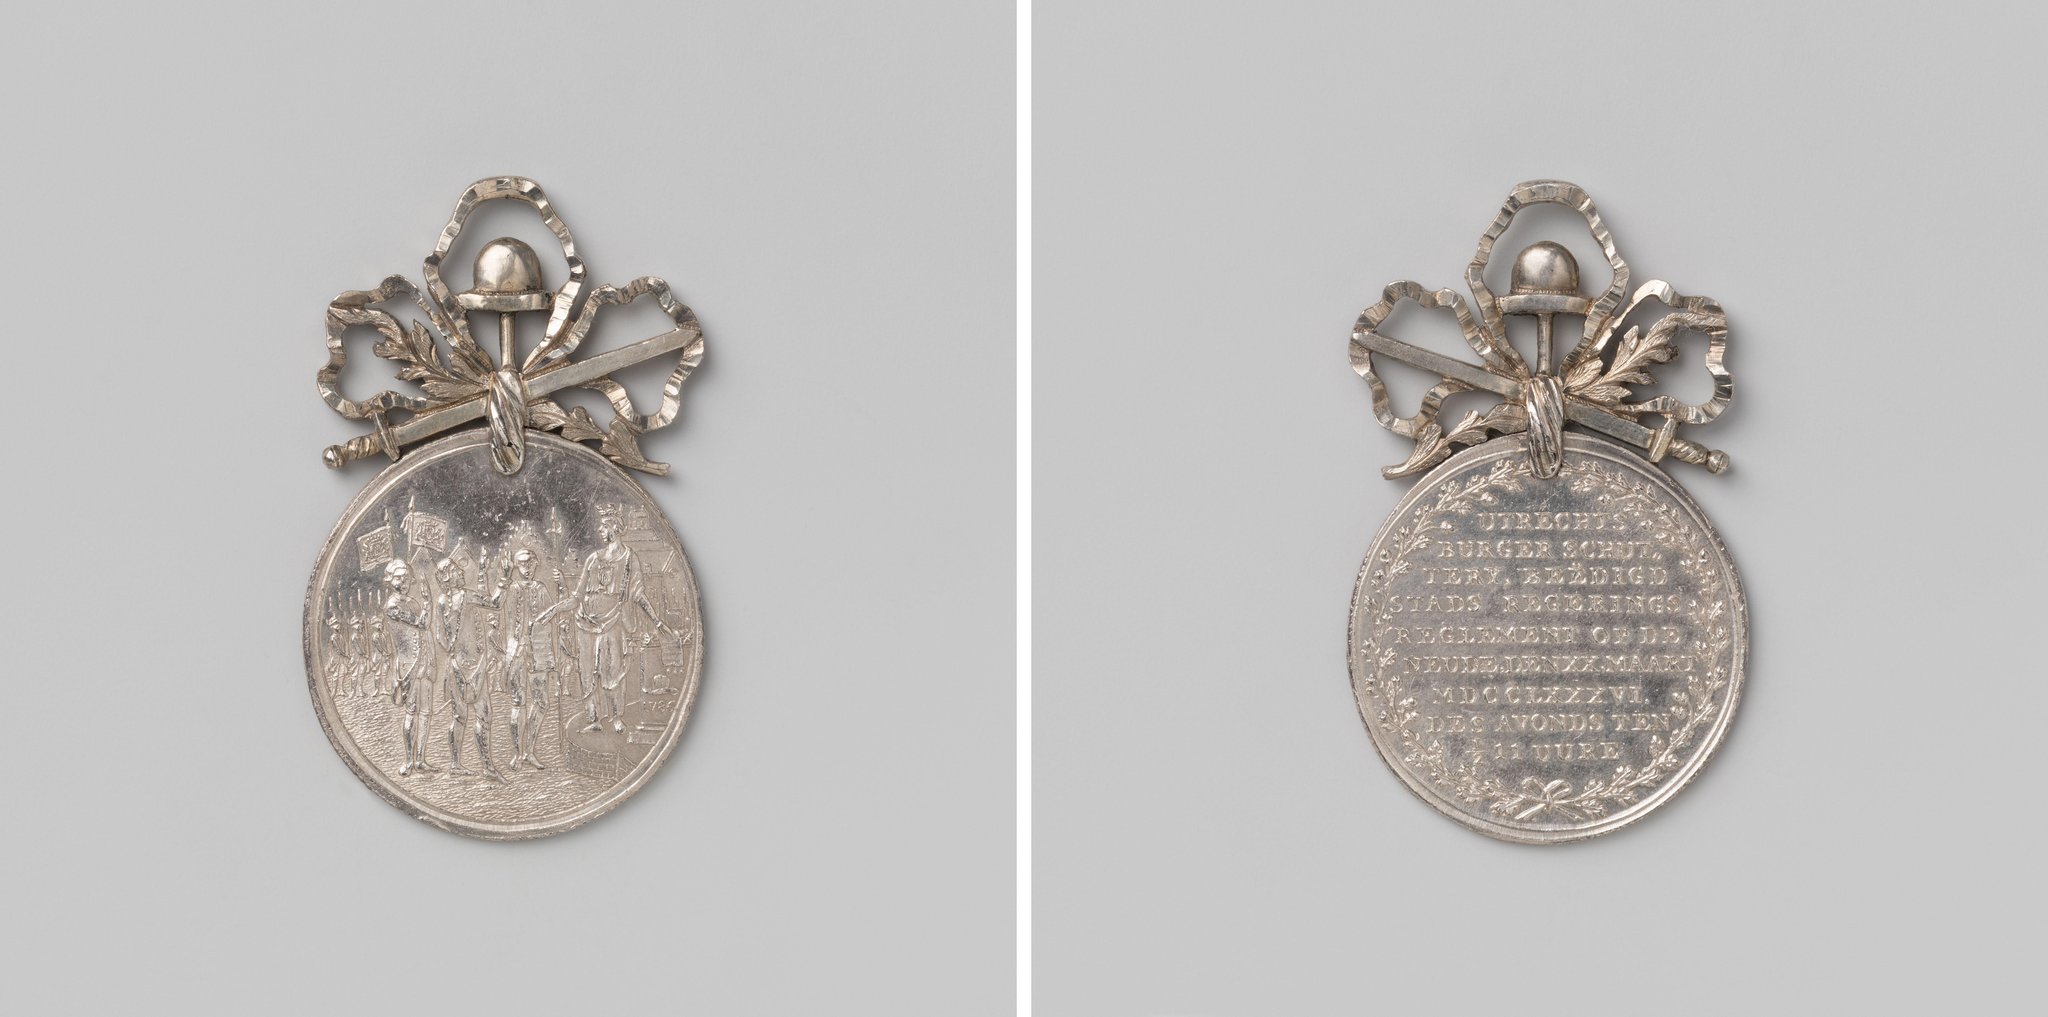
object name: insignia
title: Beëdiging van het regeringreglement door de burgerschutterij op het Neude te Utrecht, penning uitgedeeld onder de leden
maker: Anonymous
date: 1786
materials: silver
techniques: striking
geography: netherlands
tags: neude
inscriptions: inscription: ‘Utrechts Burger Schuttery, Beedigd Stads Regerings Reglement op de Neude, den XX. Maart MDCCLXXXVI. Des Avonds ten 1/2 11 Uure.’